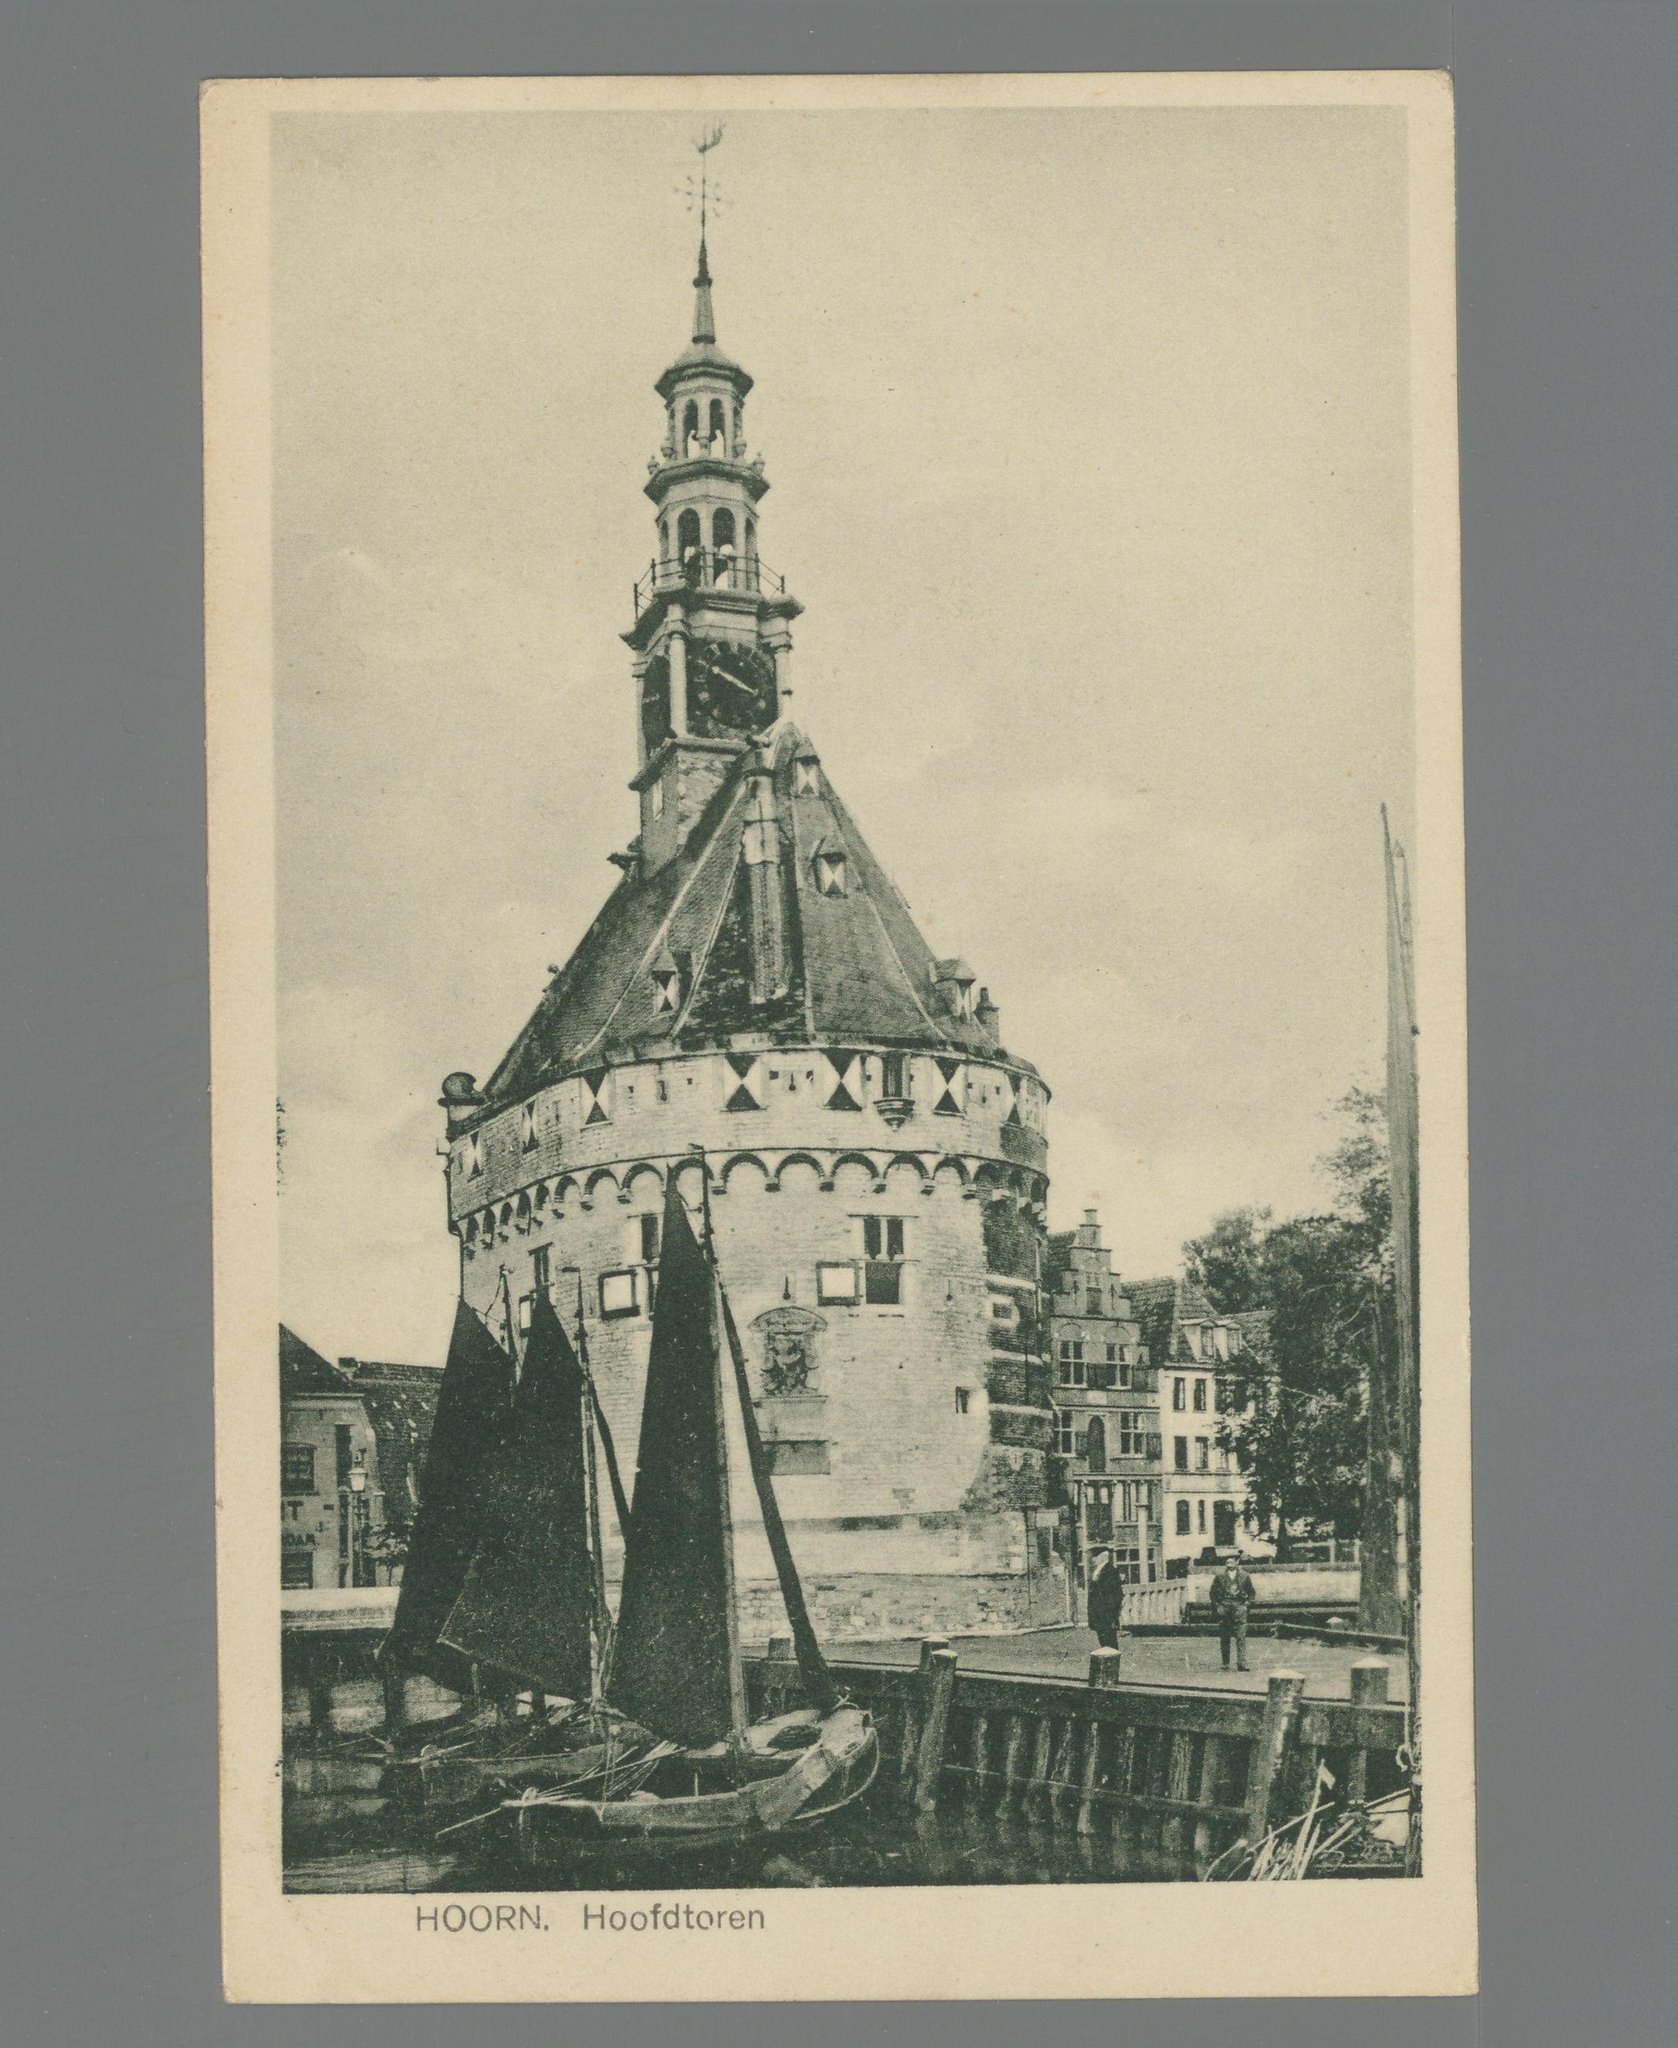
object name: ansichtkaart, prentbriefkaart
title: Hoorn. Hoofdtoren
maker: Anonymous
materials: cardboard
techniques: photograph, writing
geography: hoorn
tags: city-view, and landscape with man-made constructions, towers ~ fortified city, hoorn (north holland)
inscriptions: postage stamp